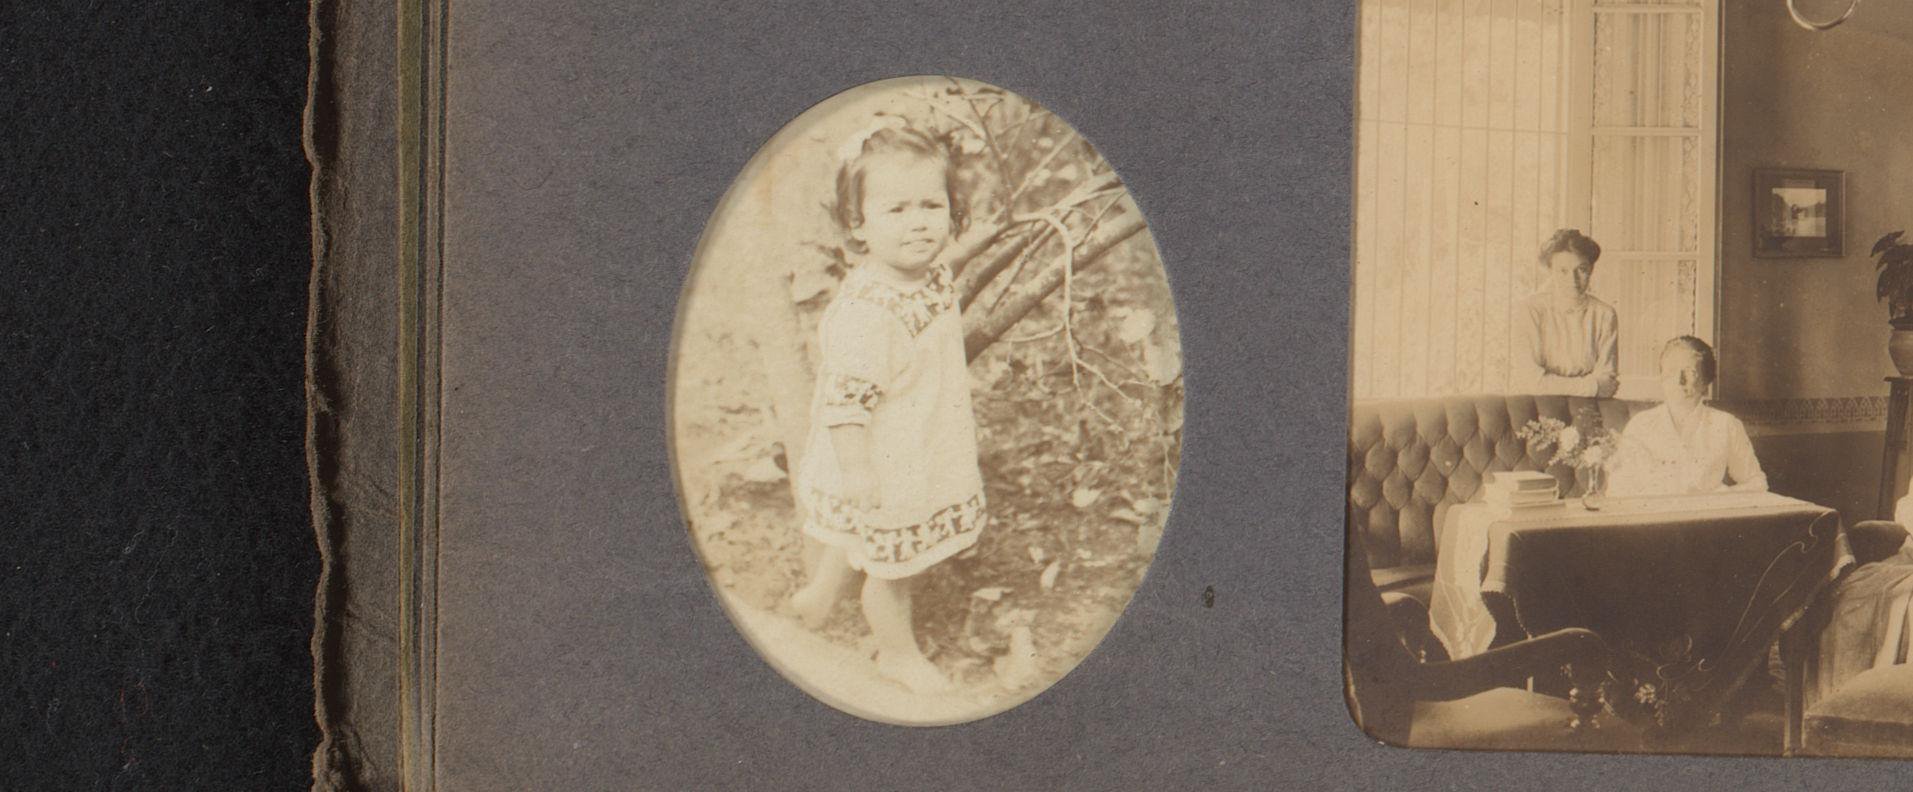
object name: photograph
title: Peuter naast een boom, aangeduid als Jenneke, mogelijk in Indonesië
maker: Anonymous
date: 1908-1912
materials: paper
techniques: gelatin silver print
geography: indonesia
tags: toddler (female), indonesia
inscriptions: inscription: ‘Jenneke’